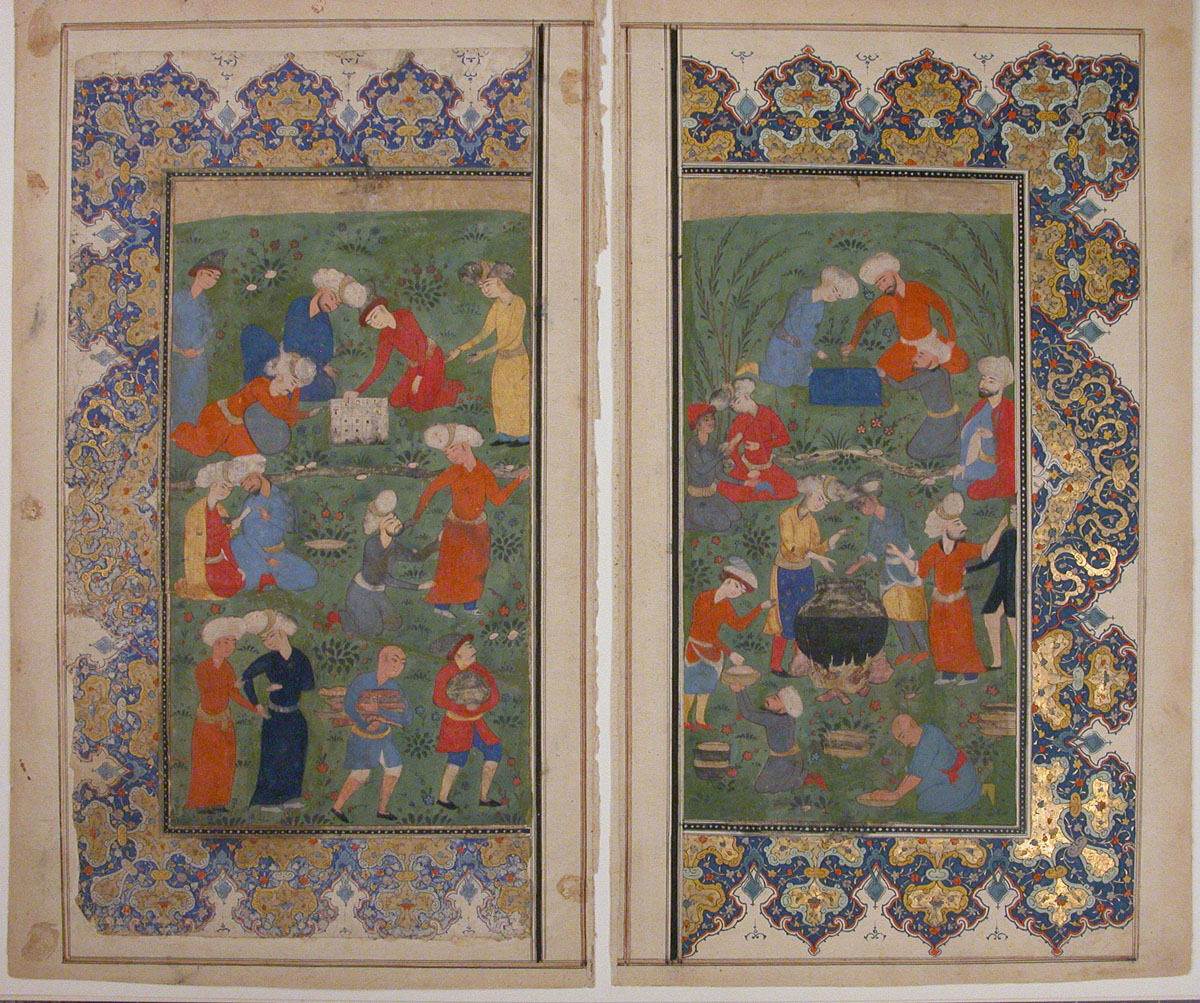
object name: folio from an illustrated manuscript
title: "Preparing a Noonday Meal on an Outing", Folio from a Kulliyat (Complete Works) of Sa'di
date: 1801-1900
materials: gold, ink, paper, watercolor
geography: india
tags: men,women,cooking